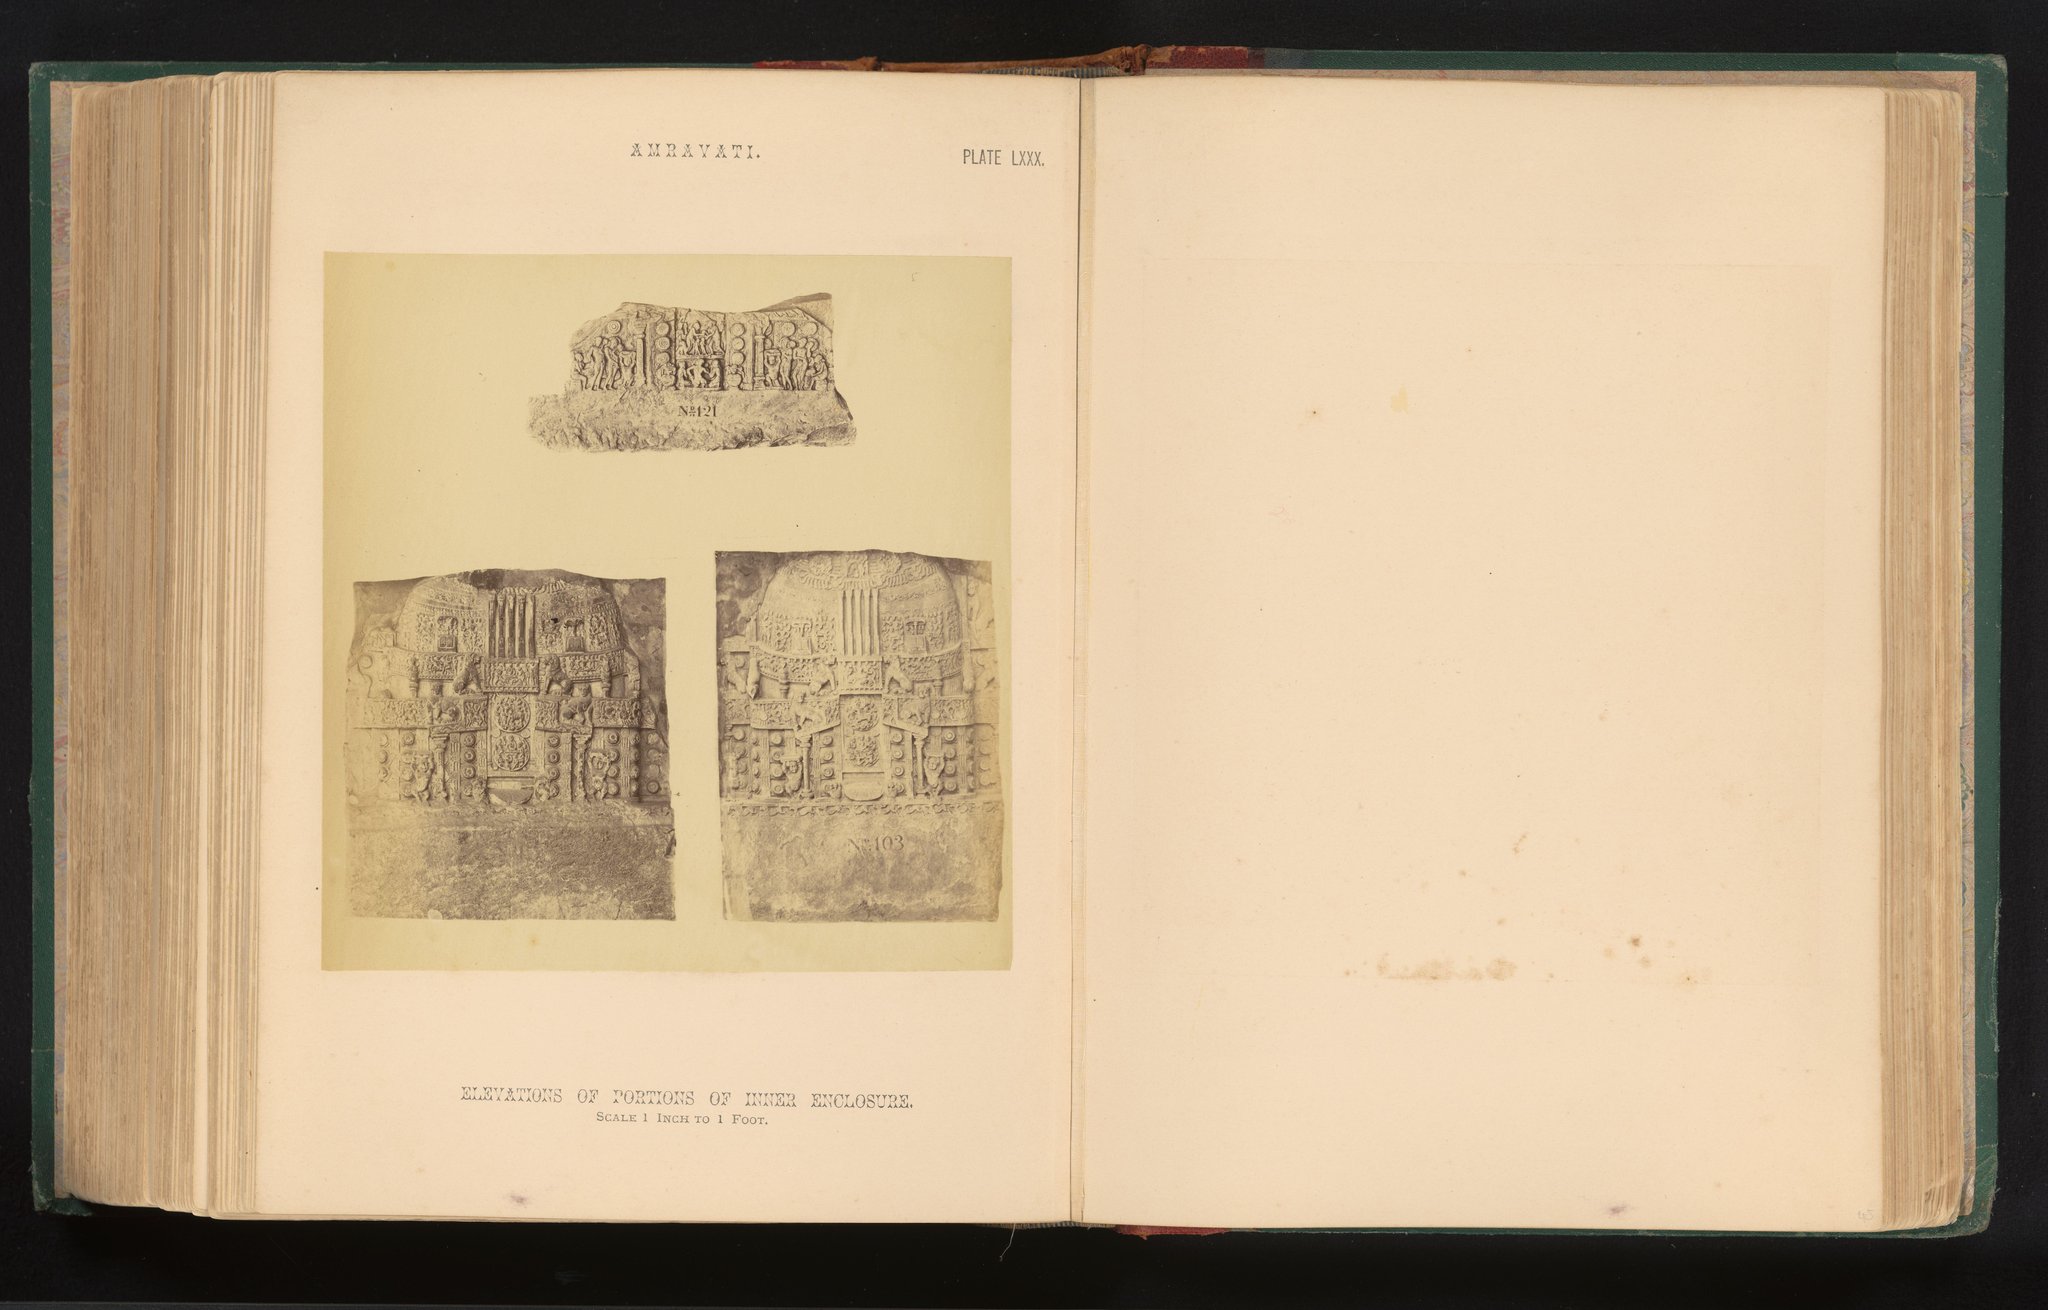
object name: photograph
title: Three reliefs with religious scenes, Amaravati, Andhra Pradesh, India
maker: william h. griggs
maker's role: printer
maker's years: 1832-1911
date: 1863-1868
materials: photographic support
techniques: albumen print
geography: amaravati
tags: hinduism, buddhism, jainism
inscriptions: inscription: ‘ELEVATIONS OF PORTIONS OF INNER ENCLOSURE./ SCALE 1 INCH TO 1 FOOT.’, inscription: ‘AMRAVATI. PLATE LXXX.’